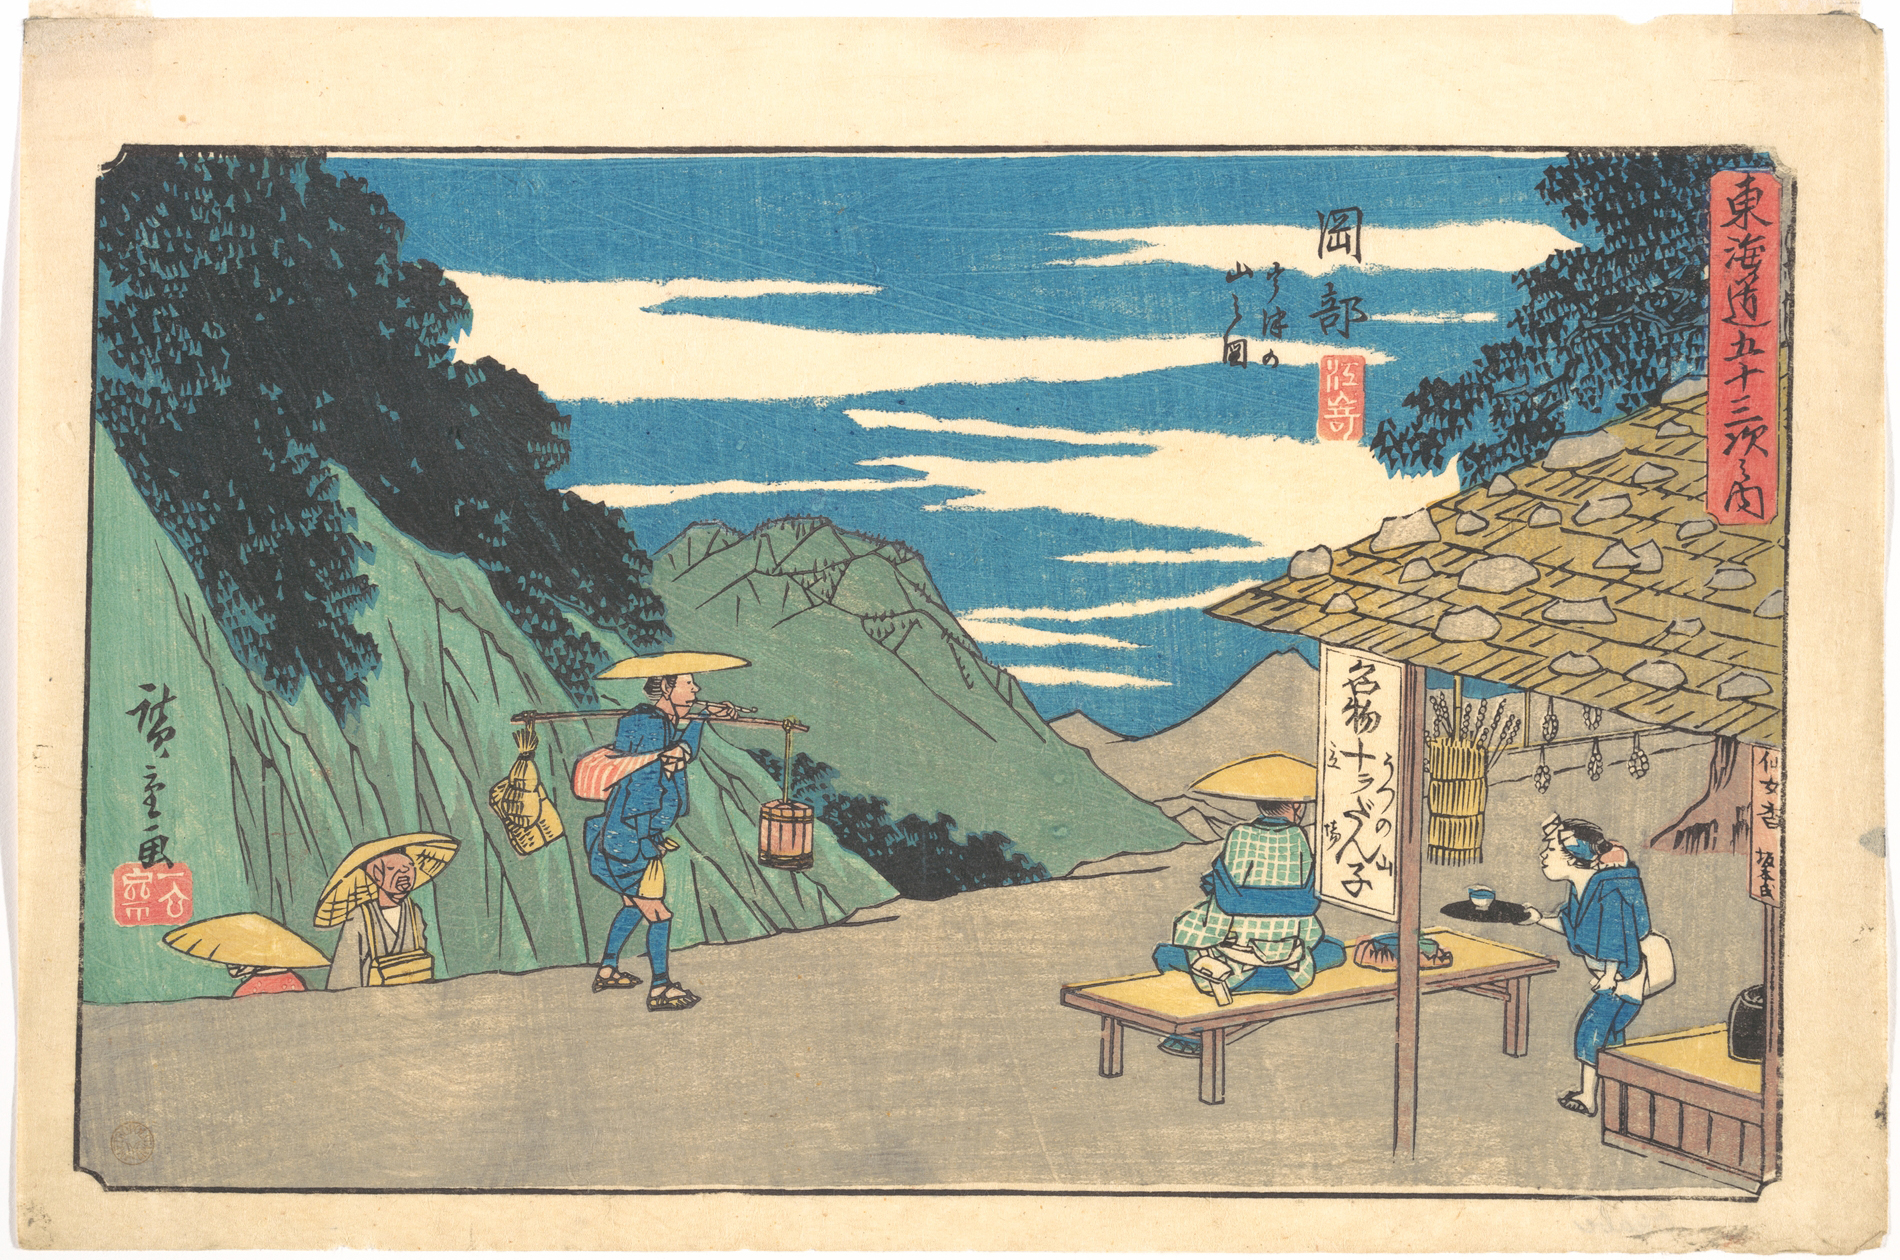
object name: print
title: Okabe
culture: japanese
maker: utagawa hiroshige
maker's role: artist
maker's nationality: japanese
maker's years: 1797-1858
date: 1842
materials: ink, paper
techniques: woodblock print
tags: men,women,mountains,tea houses